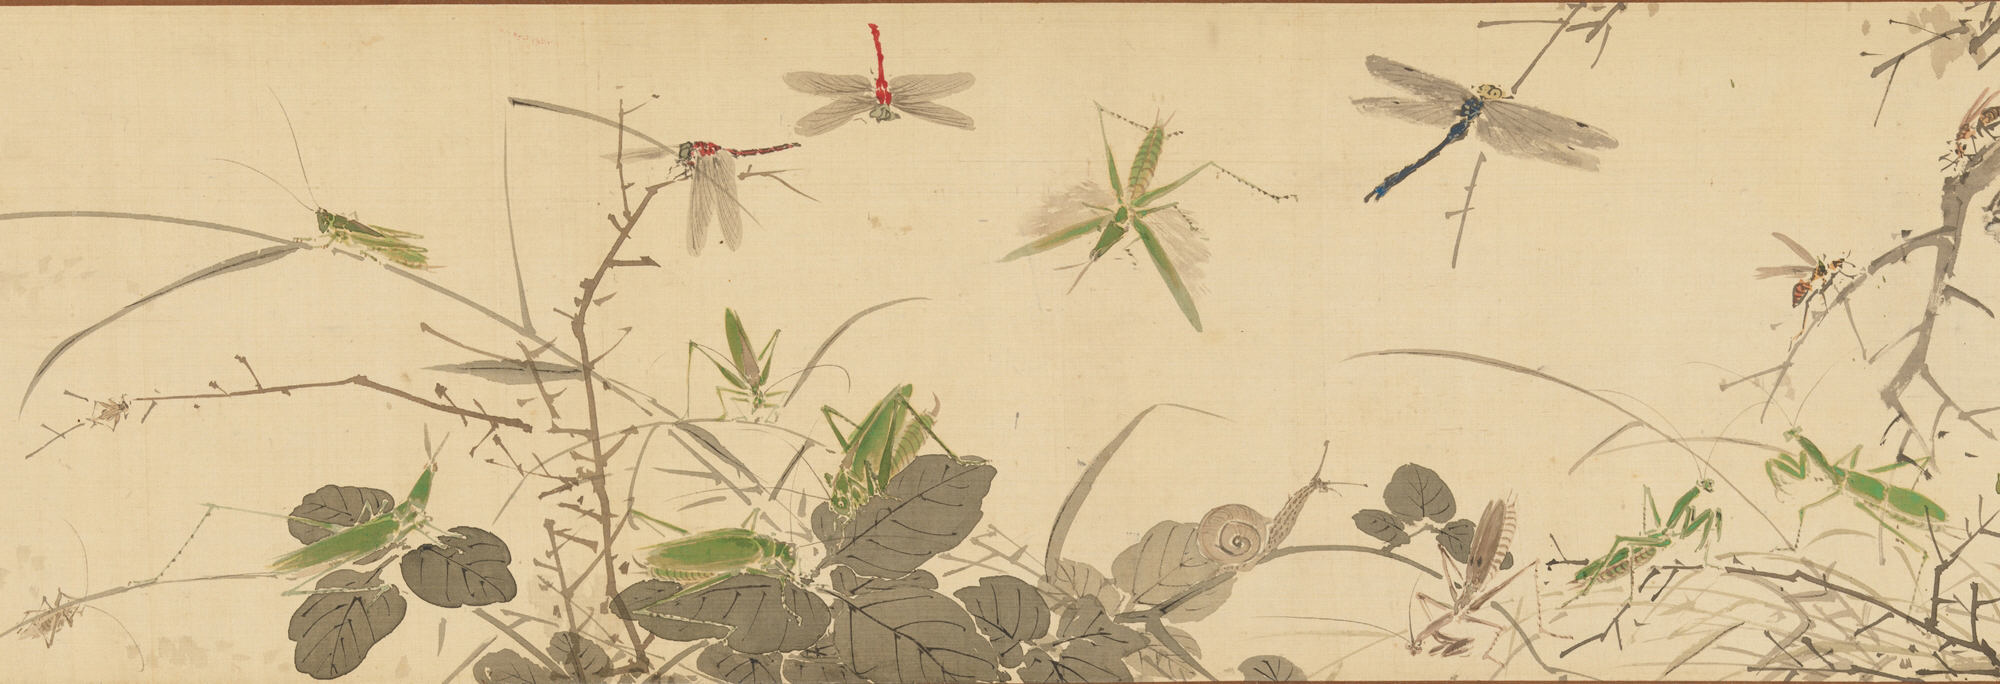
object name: handscroll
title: Insects and Grasses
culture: japanese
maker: yamamoto baiitsu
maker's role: artist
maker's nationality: japanese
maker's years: 1783-1856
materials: ink, silk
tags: insects,dragonflies